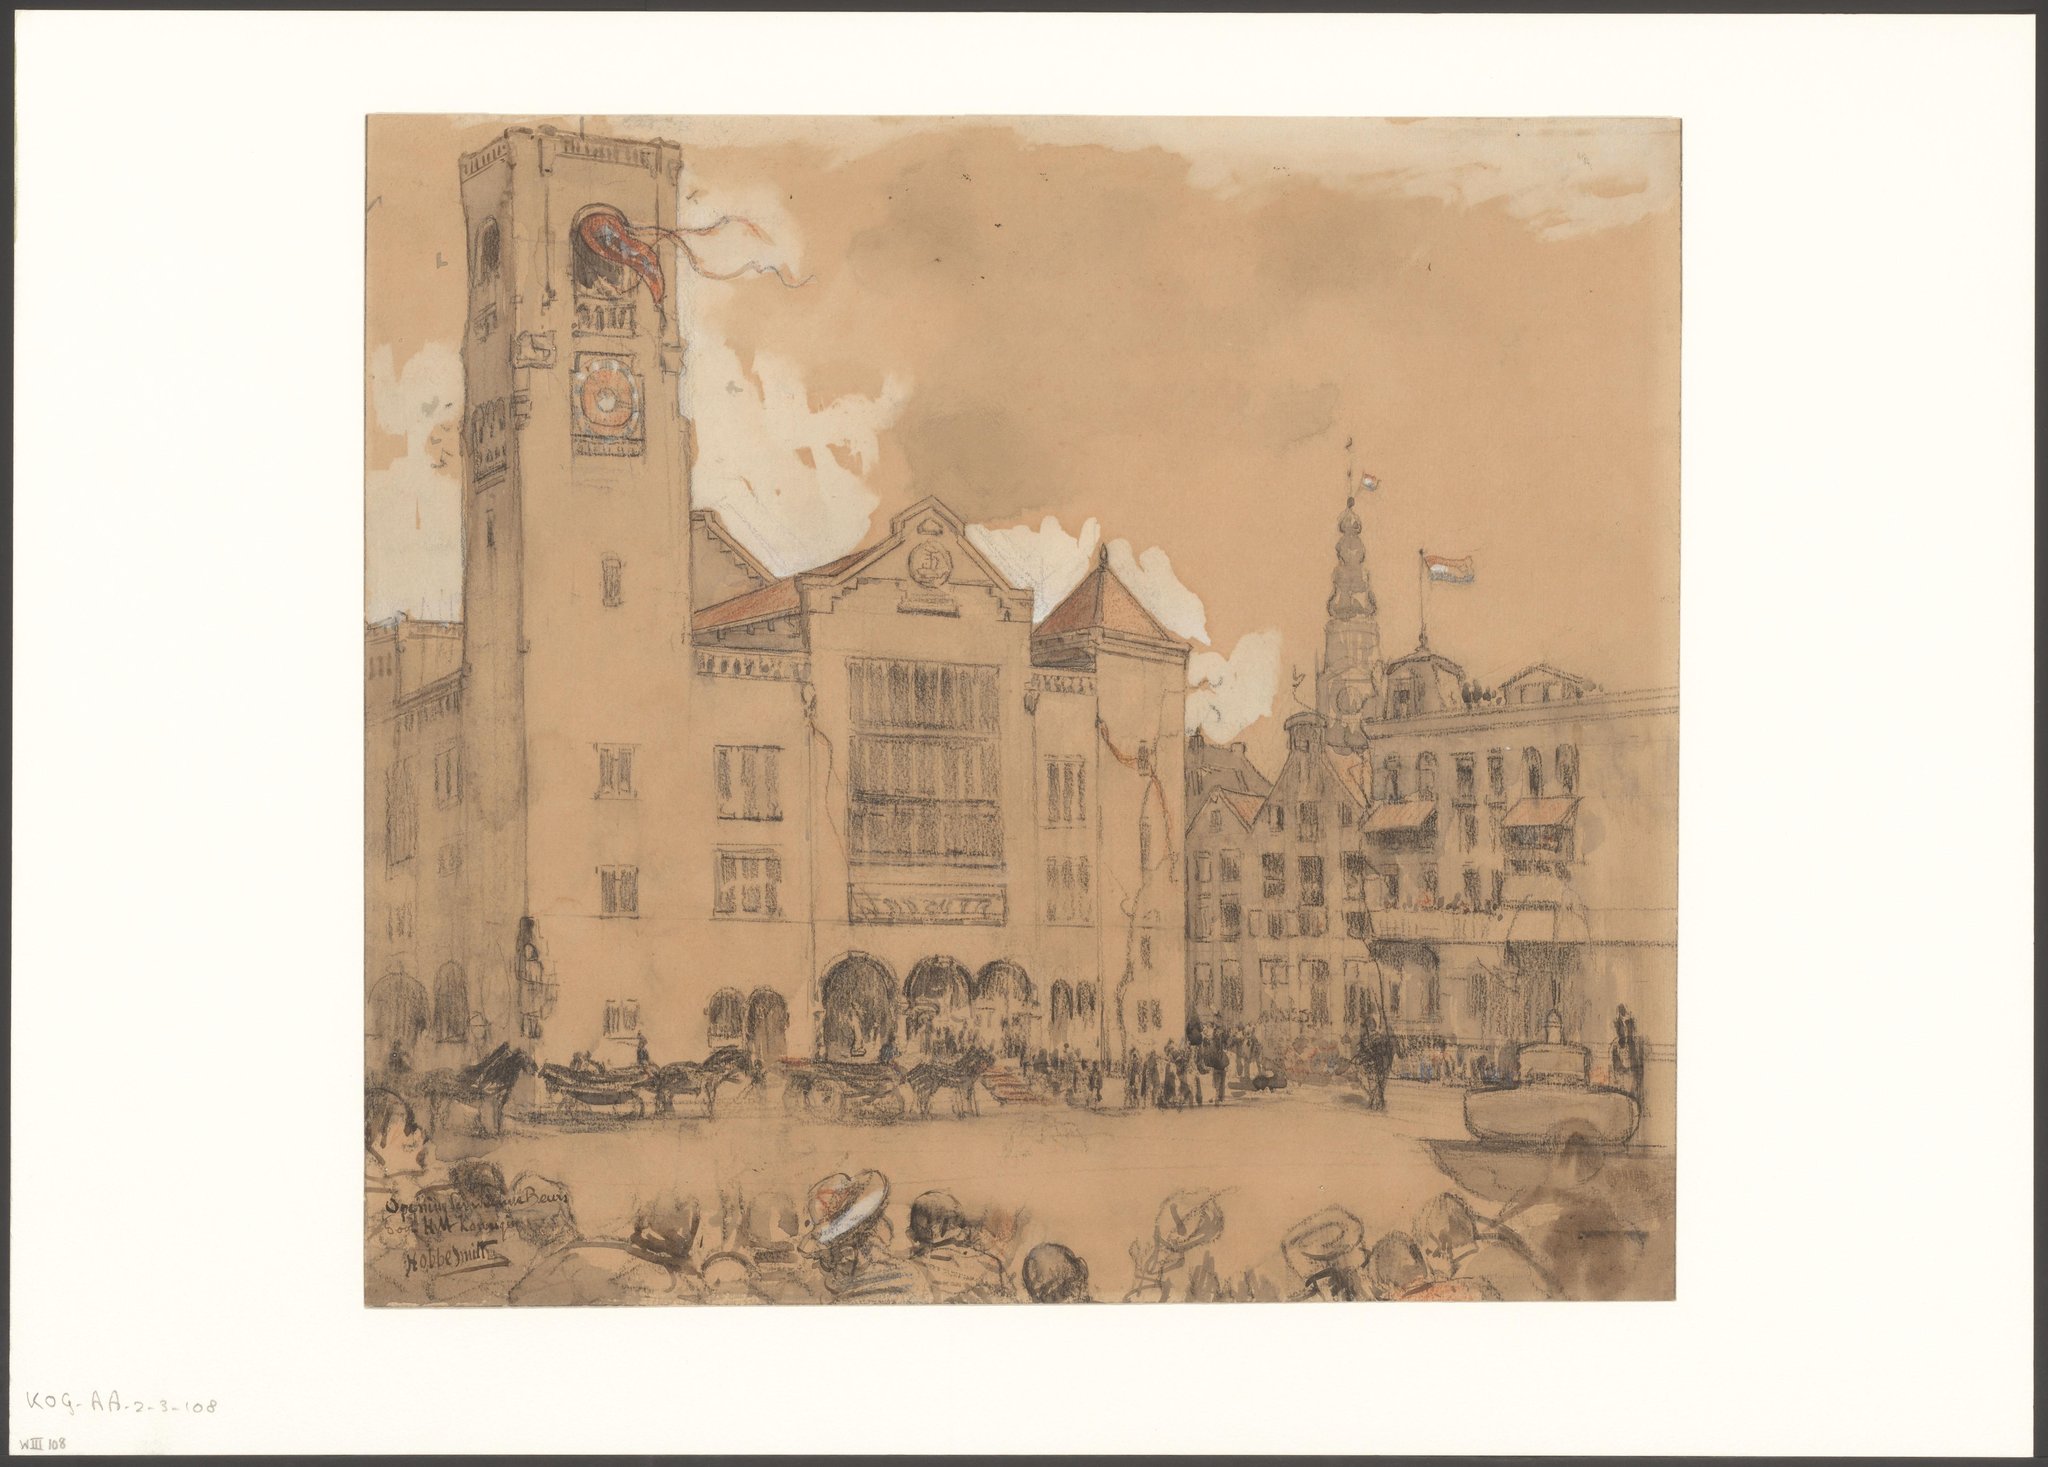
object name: drawing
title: Opening van de Beurs van Berlage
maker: hobbe smith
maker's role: painter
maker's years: 1862-1942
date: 1903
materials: chalk, paint, ink, paper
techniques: brush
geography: amsterdam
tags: square, place, circus, etc., city-view in general; 'veduta', stock exchange, stock-market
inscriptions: signature: ‘Hobbe Smith’, inscription: ‘Opening der Nieuwe Beurs / HM Koningin’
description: Tekening binnen de Atlas Van Eck ingedeeld op wijknummer 3.